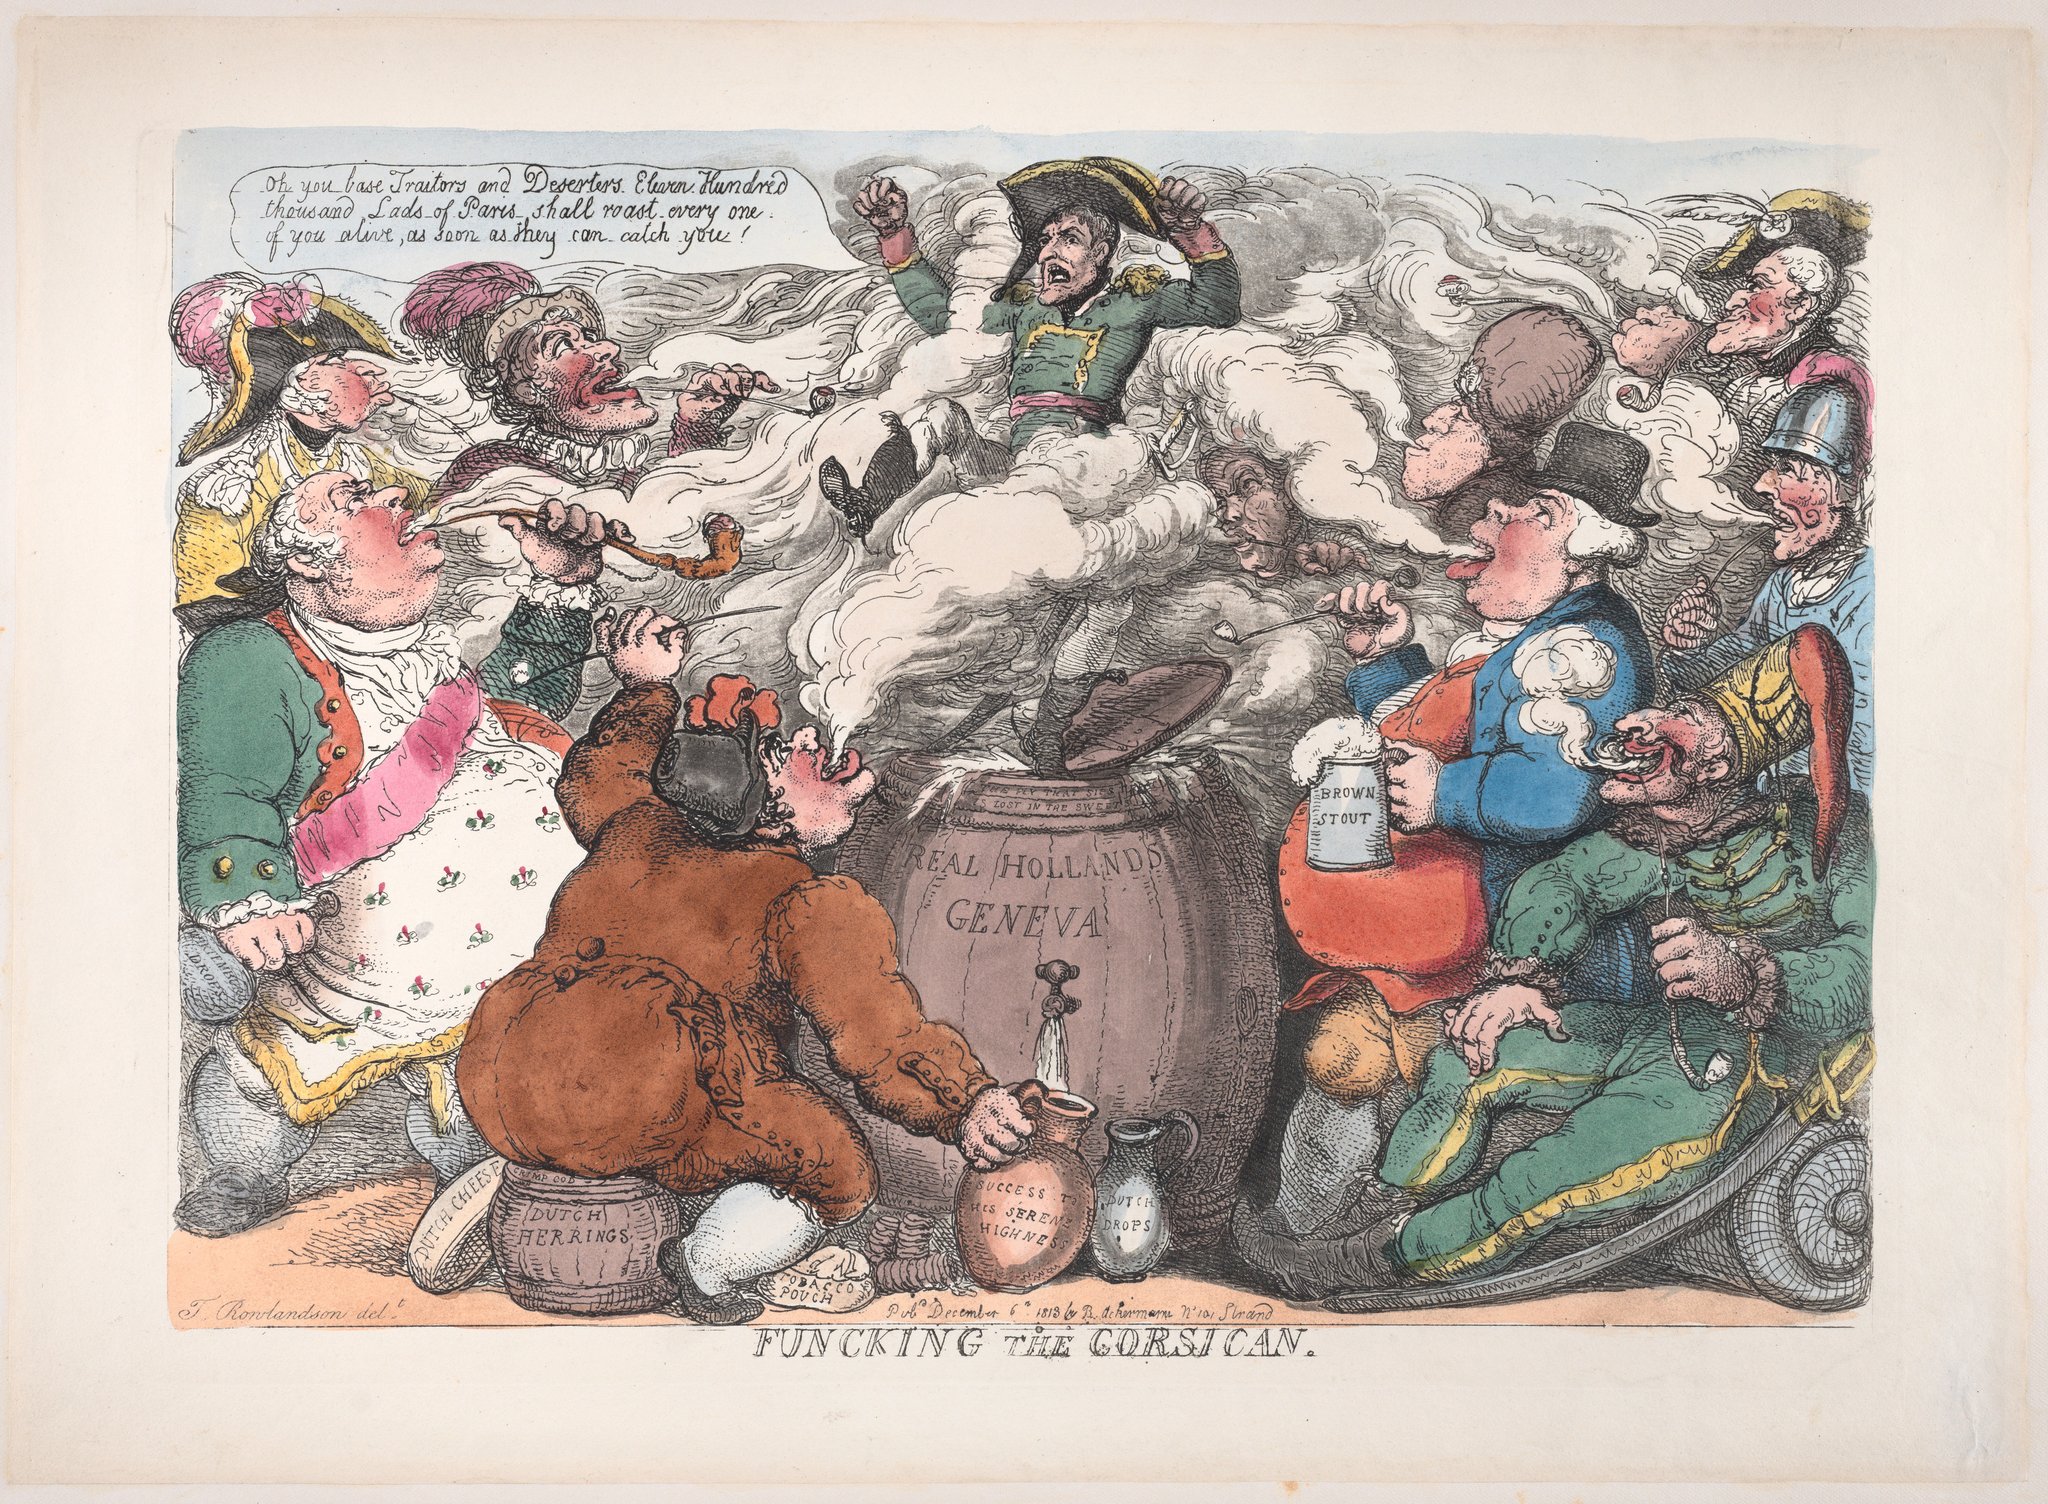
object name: print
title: Funcking the Corsican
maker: thomas rowlandson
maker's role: artist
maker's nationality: british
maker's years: 1757-1827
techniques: etching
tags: satire,napoleon i,men,politics